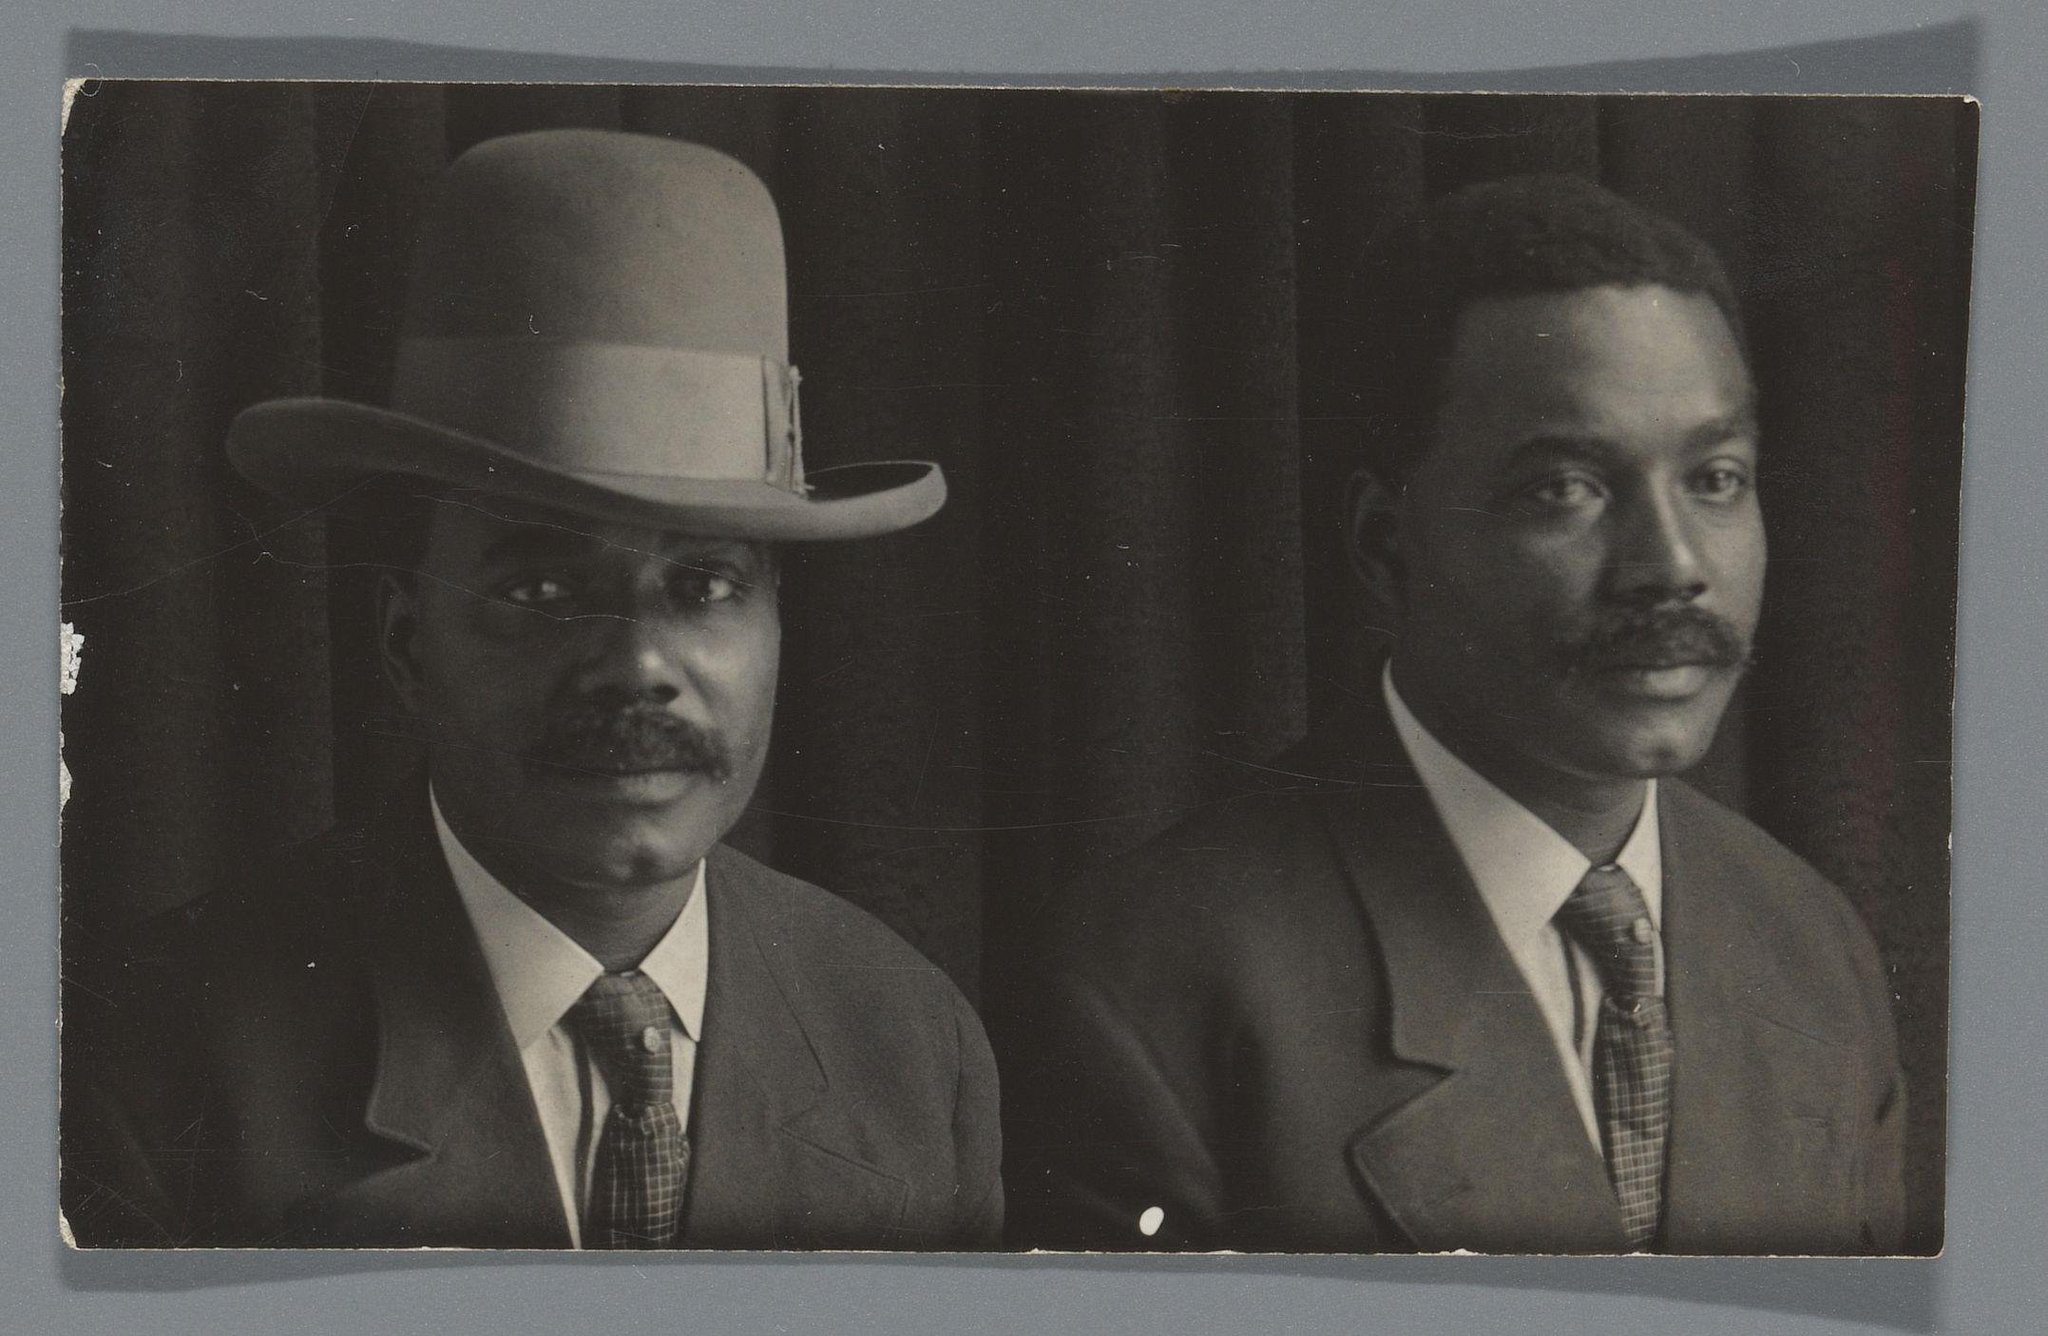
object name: photograph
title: Portret van een Zwarte Amerikaanse man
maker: Anonymous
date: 1950-1959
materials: photographic support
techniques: gelatin silver print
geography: united states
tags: united states of america